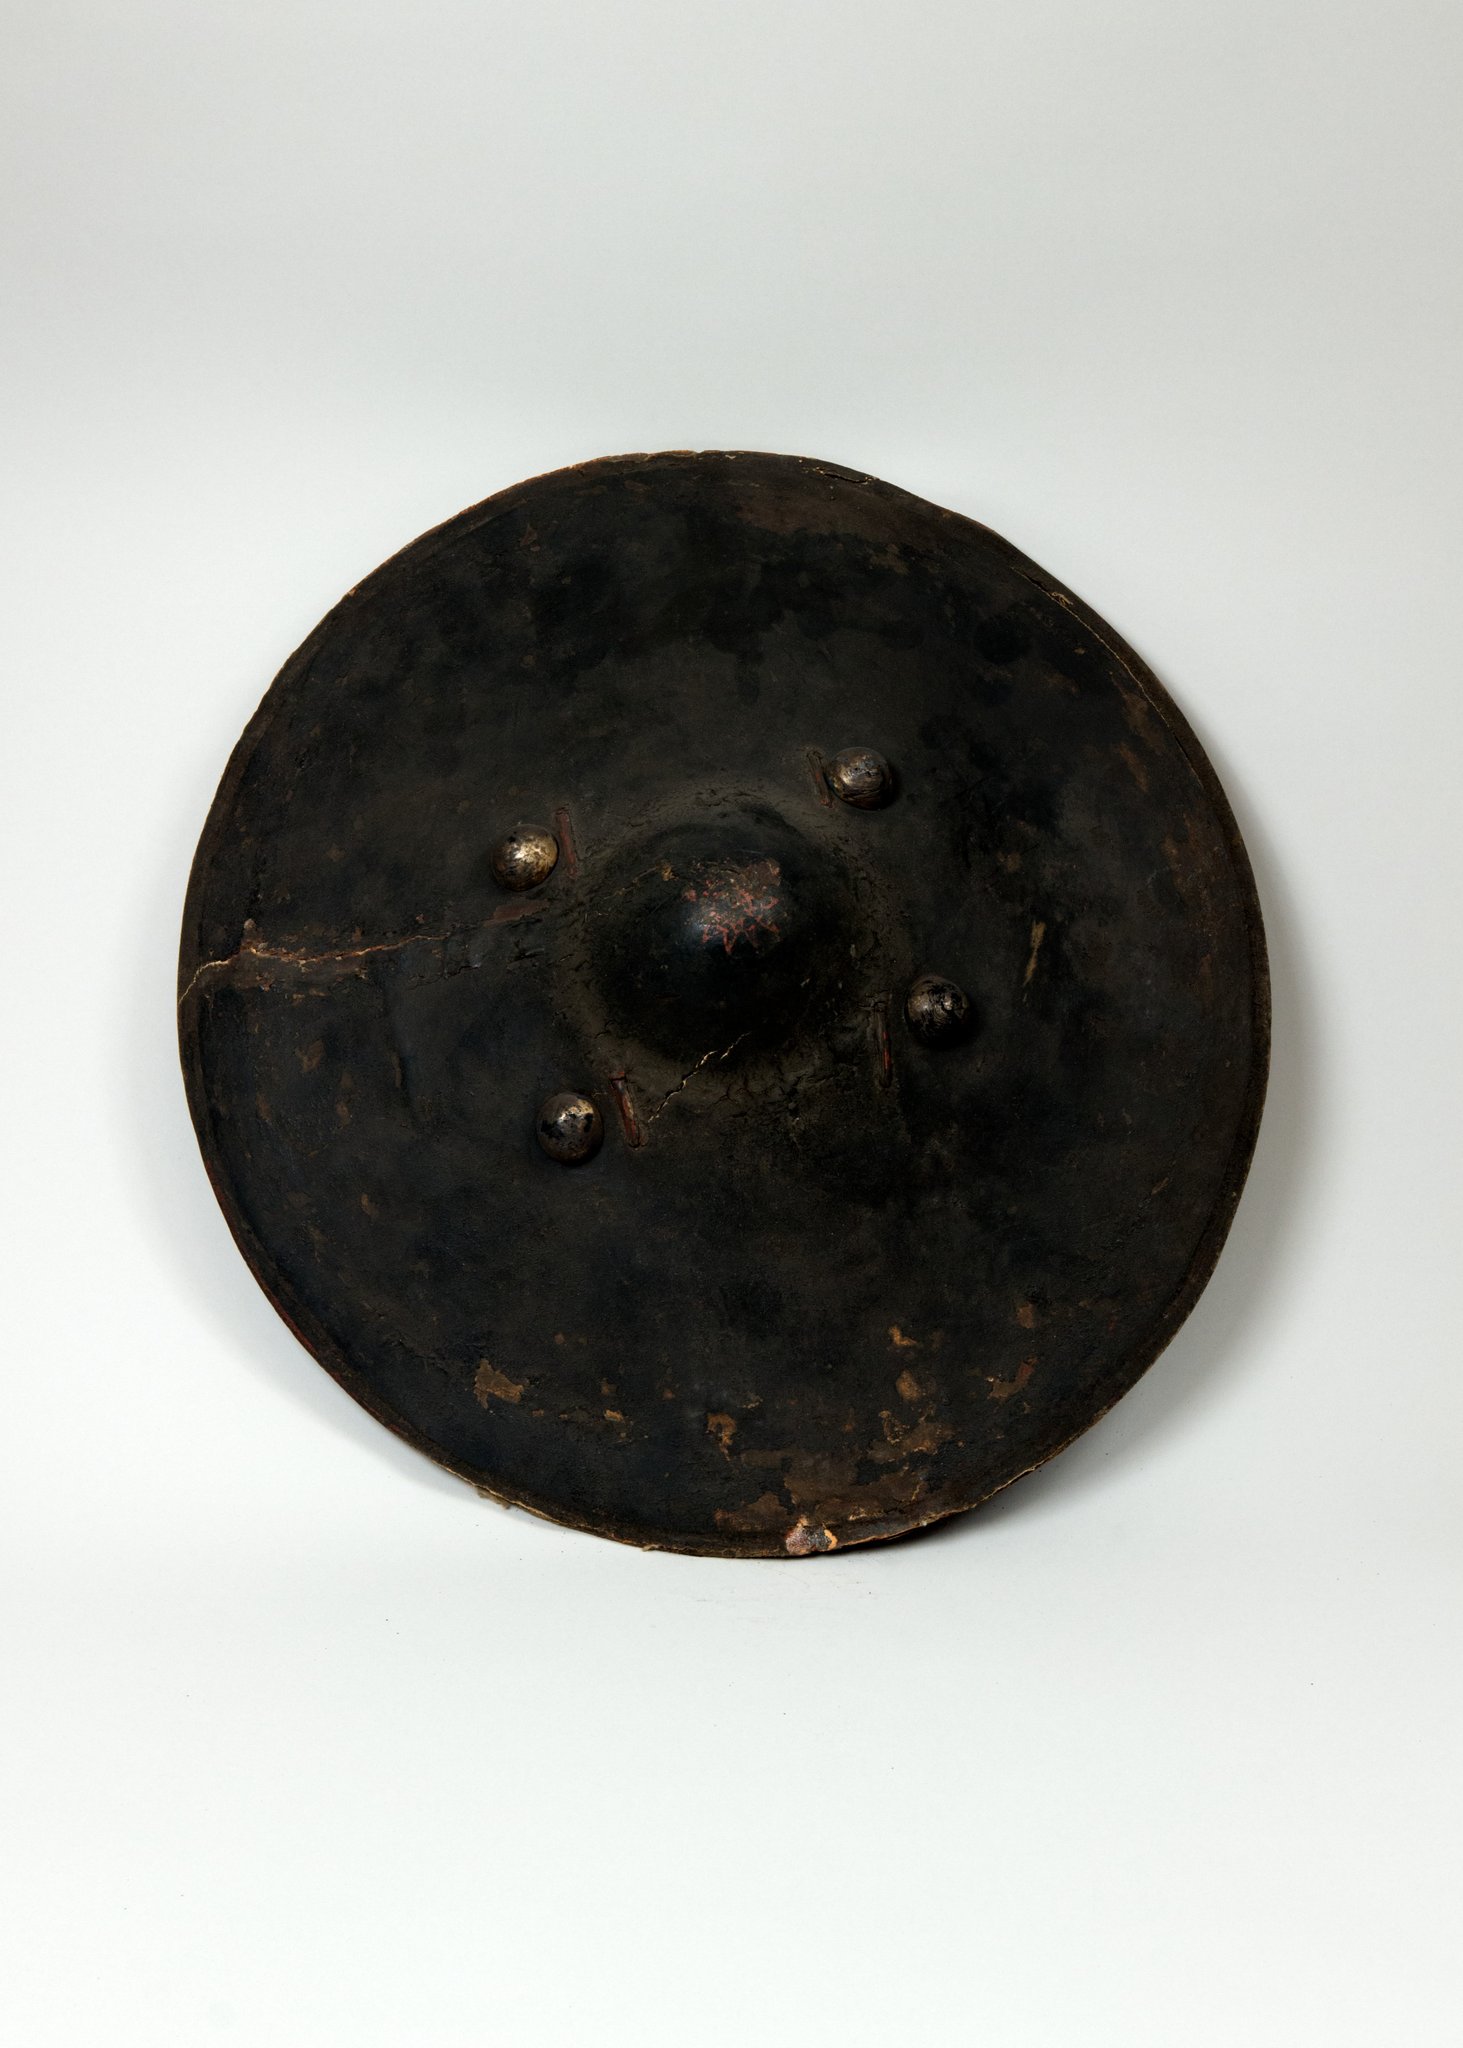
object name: shield dhàl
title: Shield (Dhàl)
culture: indian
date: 1801-1900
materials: iron, lacquer, silver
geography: india